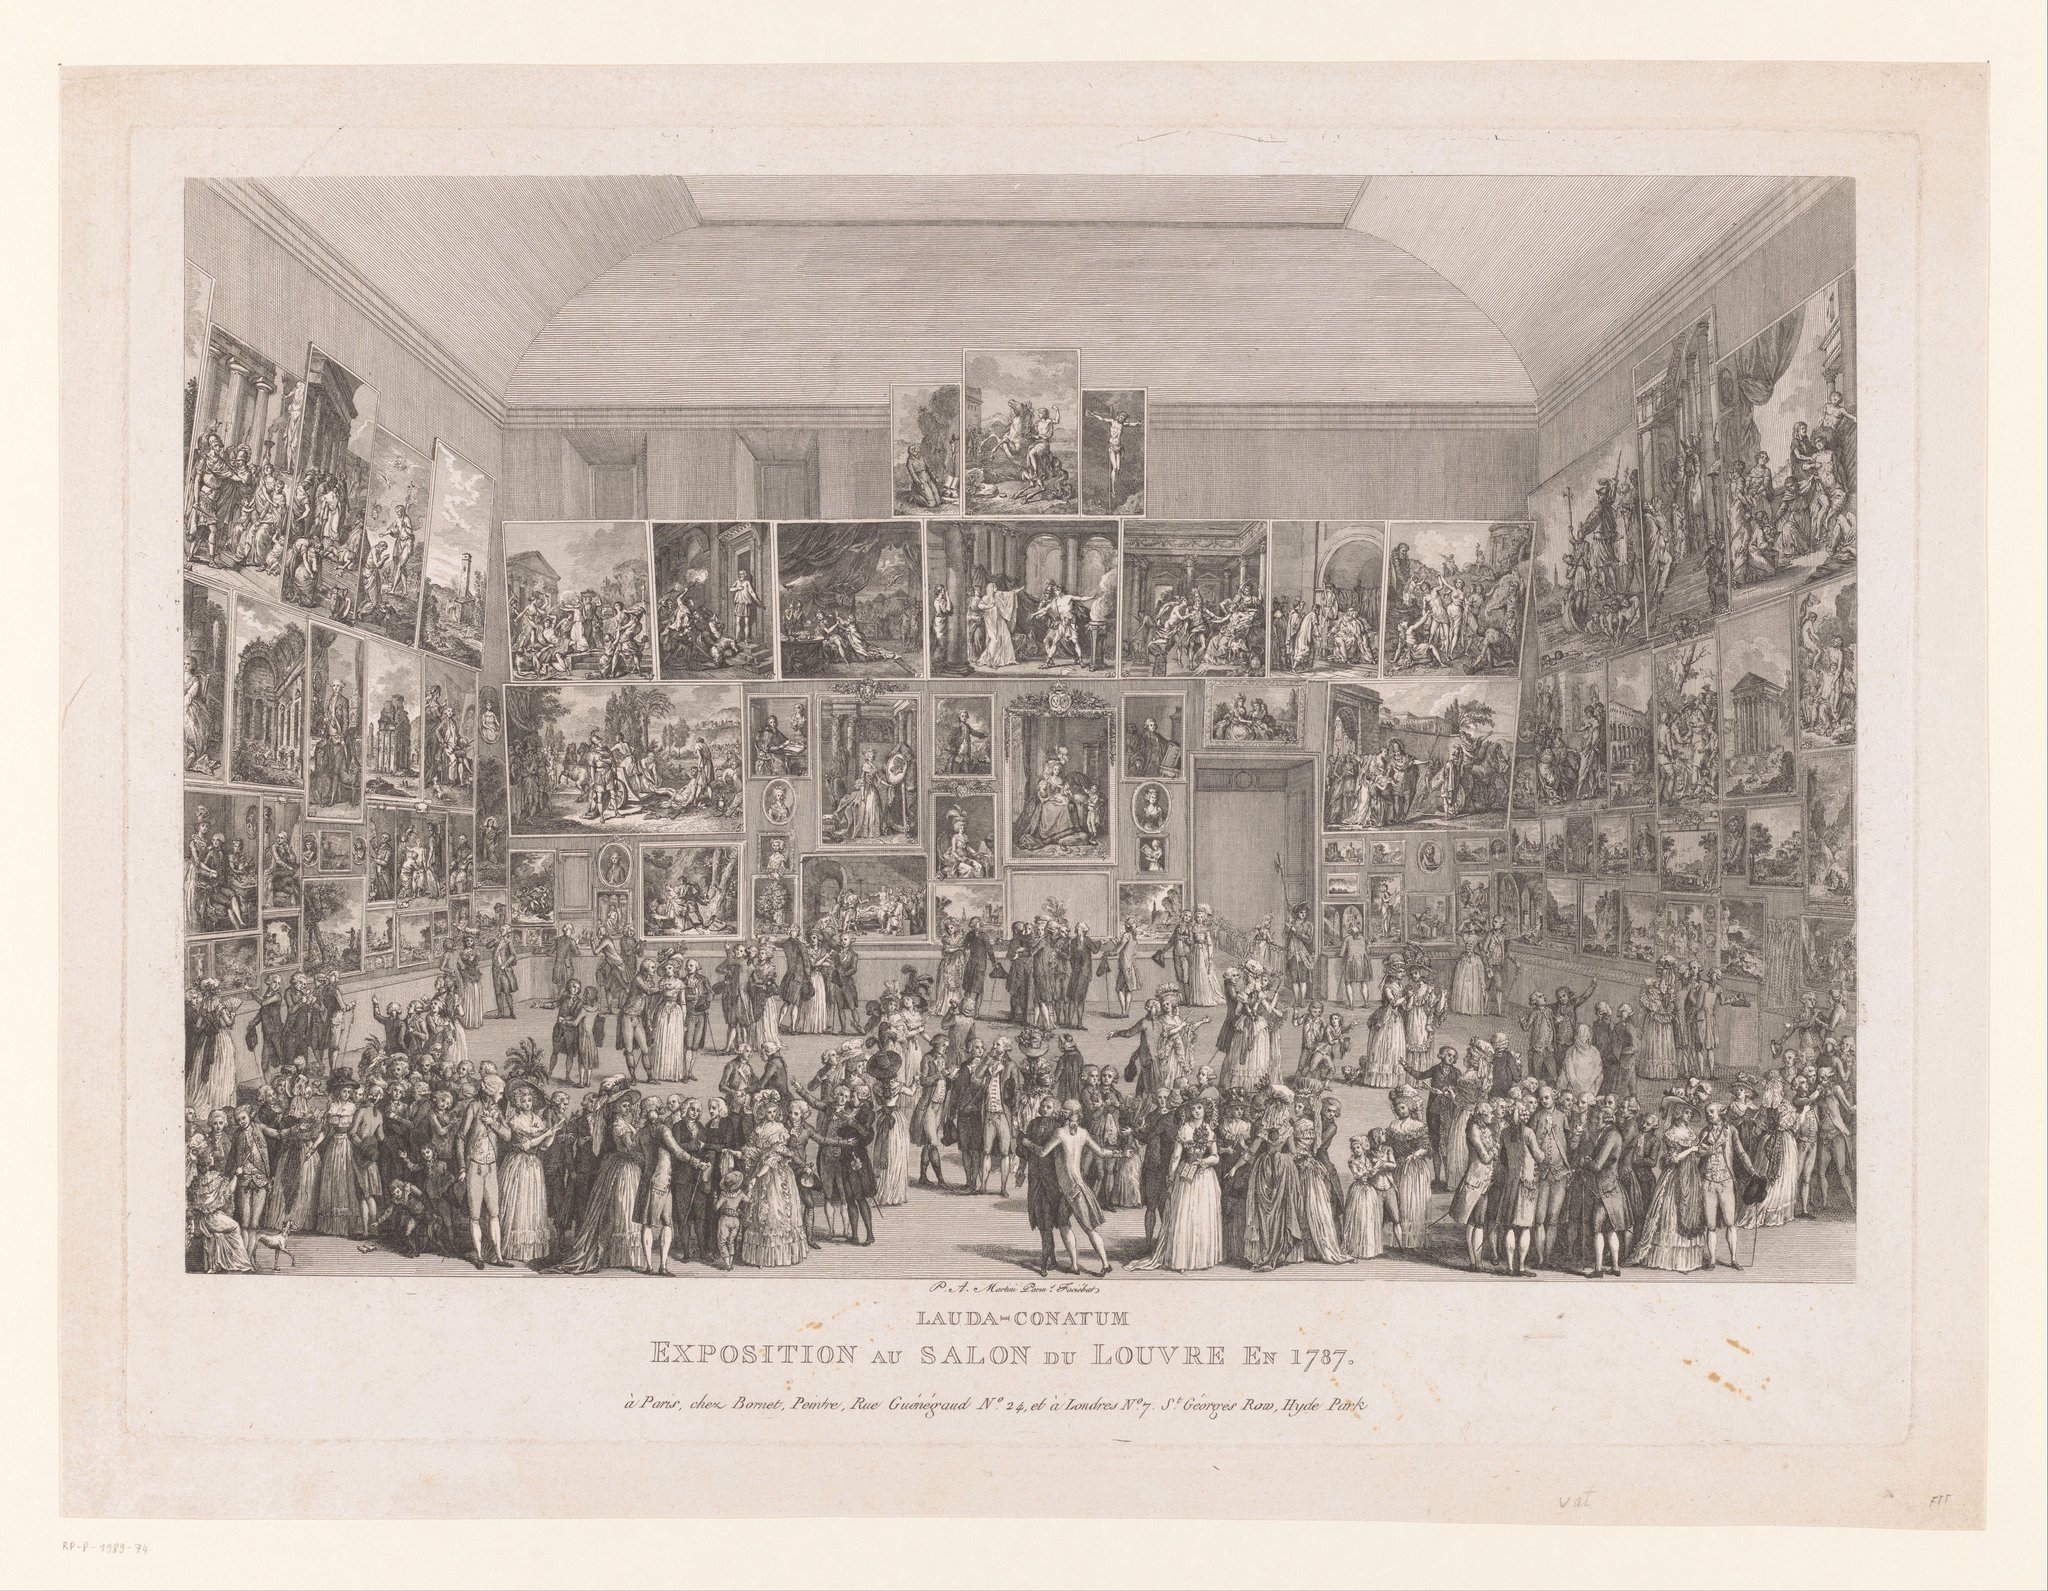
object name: print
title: Tentoonstelling in het Louvre in 1787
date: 1787-1797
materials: paper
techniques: engraving, etching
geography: london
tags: exhibition ~ art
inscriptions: collector's mark: Lugt 2228, collector's mark: Lugt 2760